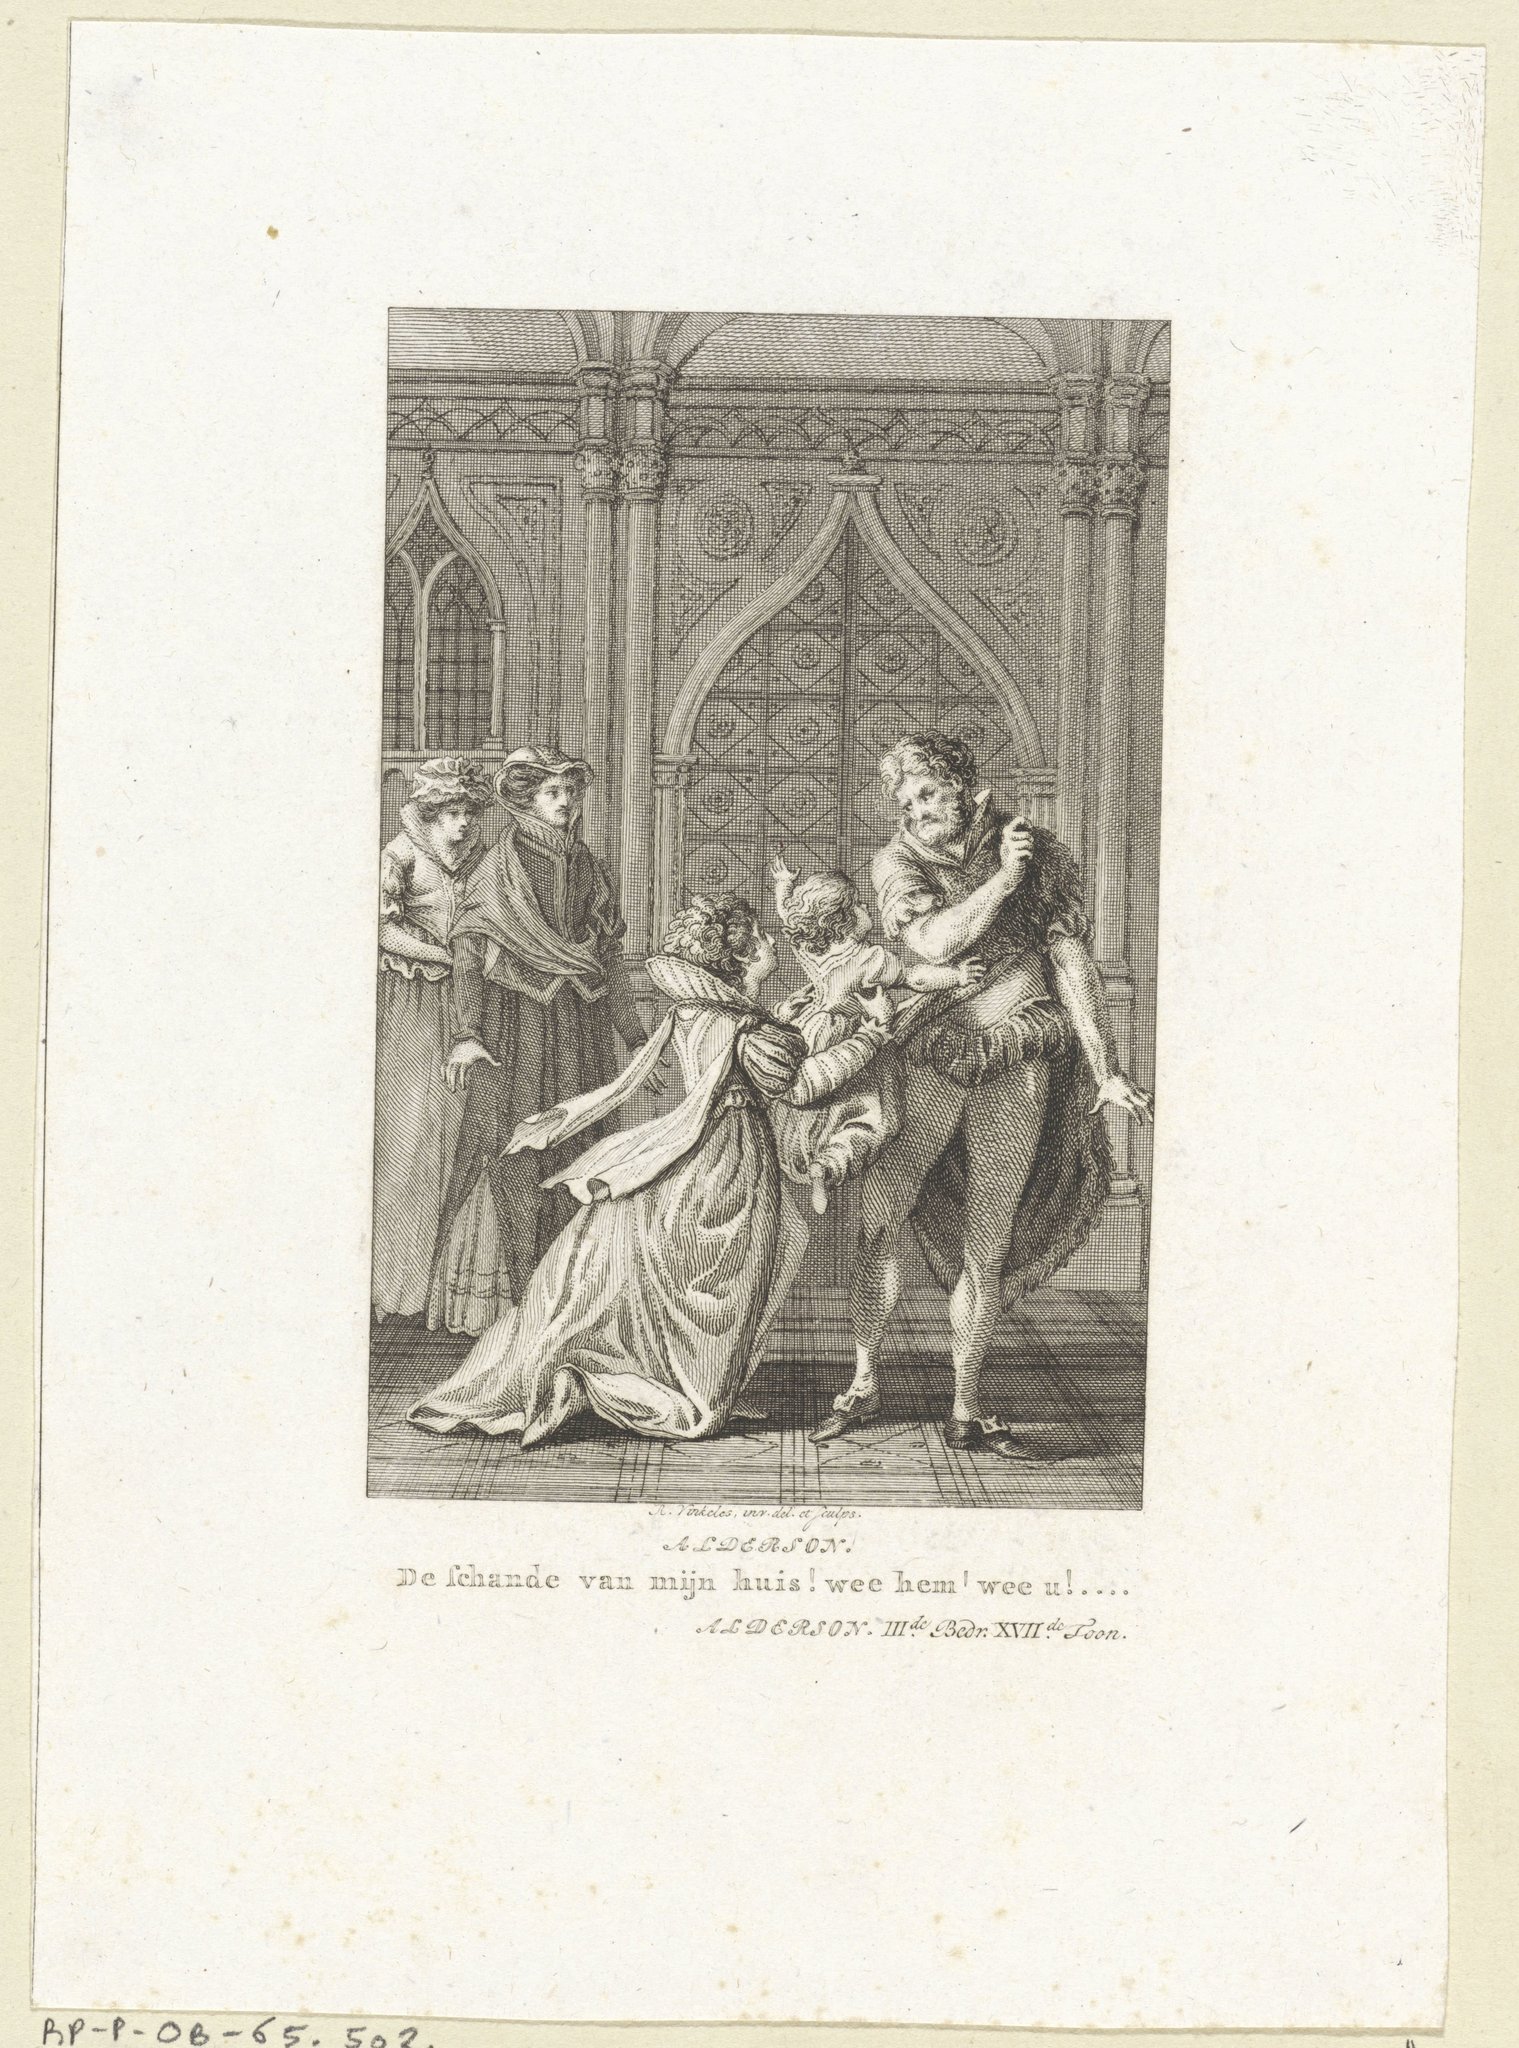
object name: print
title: Vrouw presenteert een kind aan een man, die het afwijst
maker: reinier vinkeles (i)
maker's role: draughtsman, print maker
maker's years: 1741-1816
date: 1800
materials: paper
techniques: engraving, etching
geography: amsterdam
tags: rejection, illegitimate child, bastard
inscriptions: collector's mark: Lugt 240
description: Deze prent is mogelijk ook gebruikt als illustratie in: Brandes, Johann Christian. Alderson: Treurspel. Amsterdam: Gerrit Warnars, 1800.